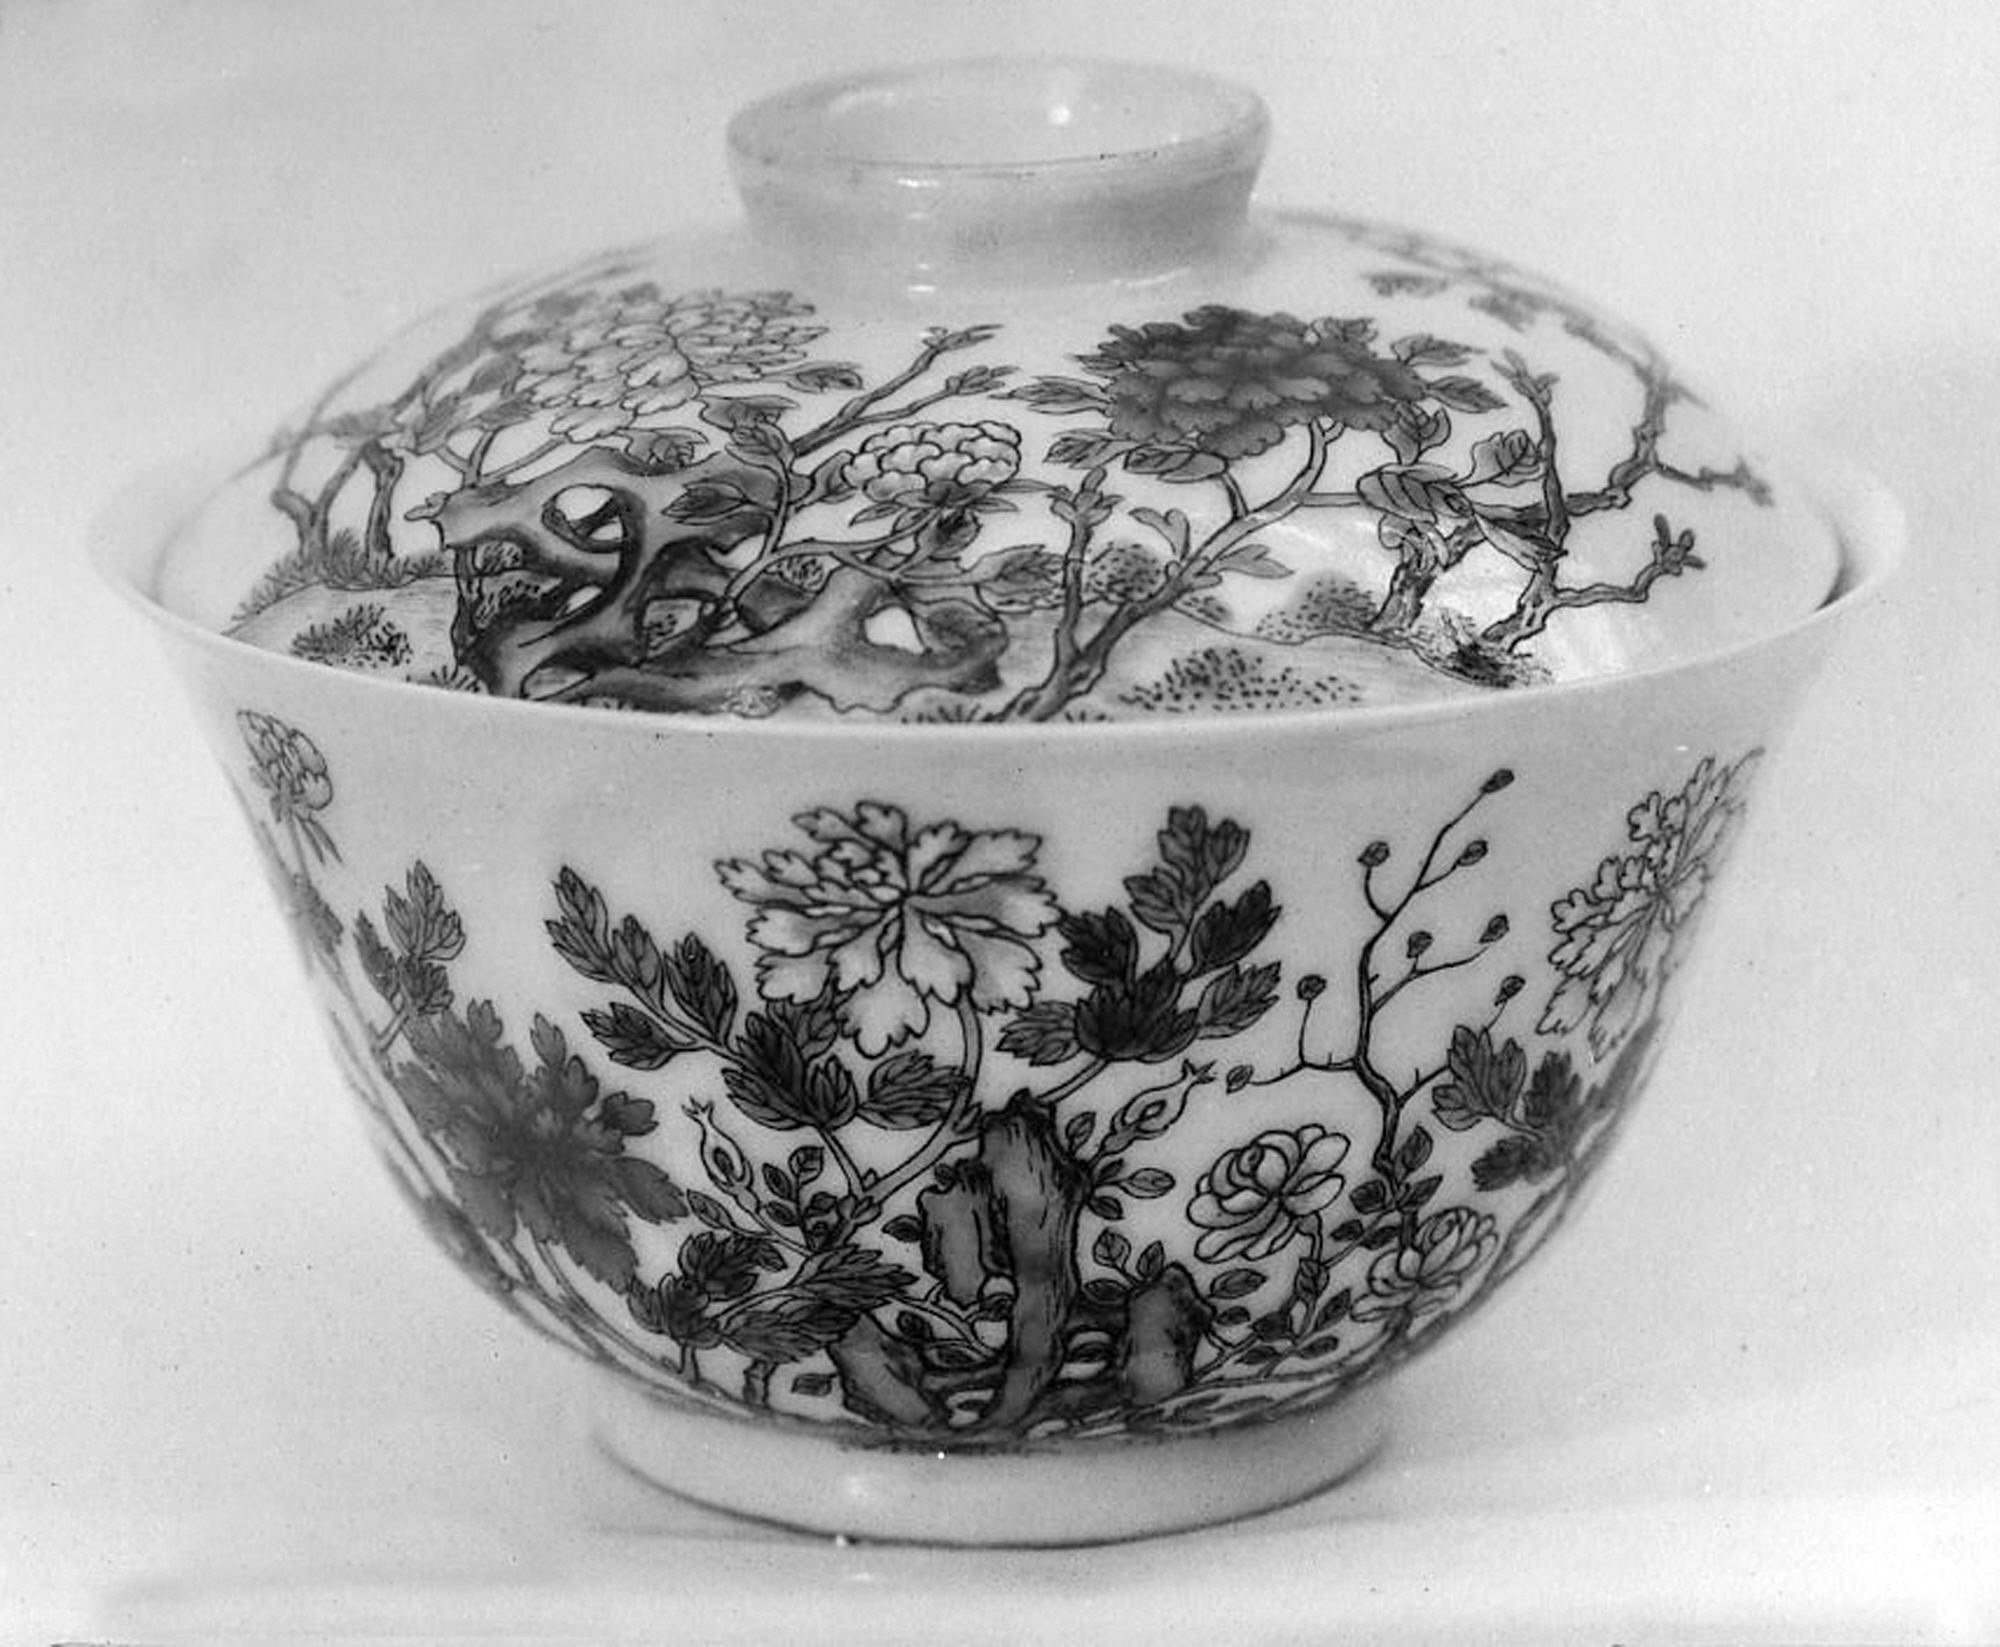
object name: covered cup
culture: chinese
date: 1736-1795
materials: porcelain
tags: flowers,leaves,trees